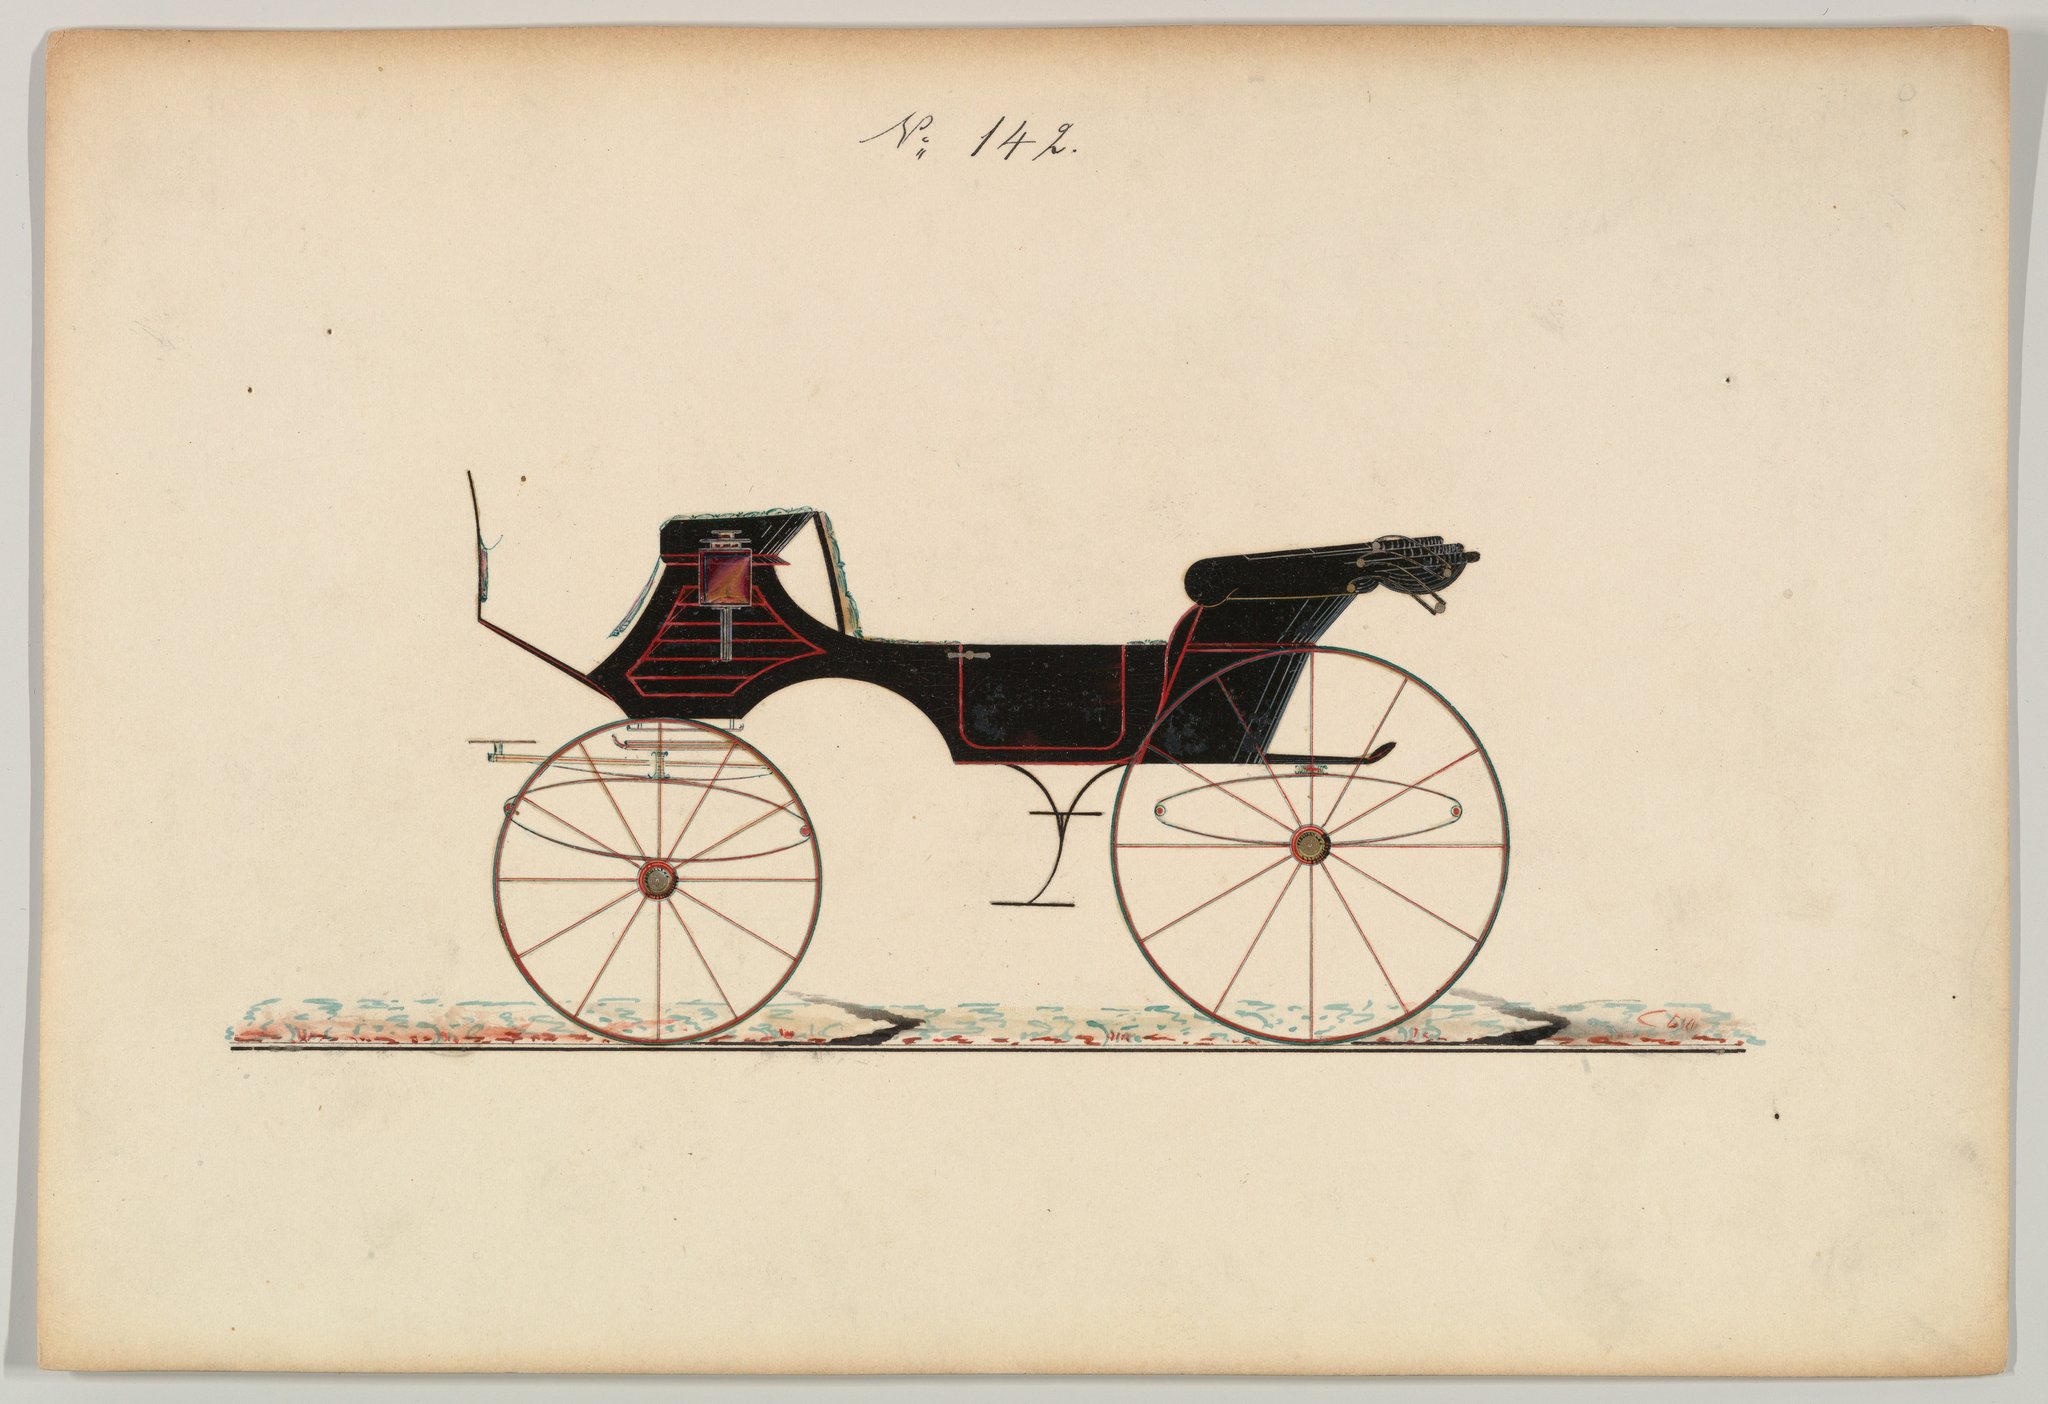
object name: drawing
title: Design for Vis-à-vis, no. 142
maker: brewster & co.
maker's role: manufacturer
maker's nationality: american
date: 1880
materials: gouache, gum arabic, ink, watercolor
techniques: pen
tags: carriages